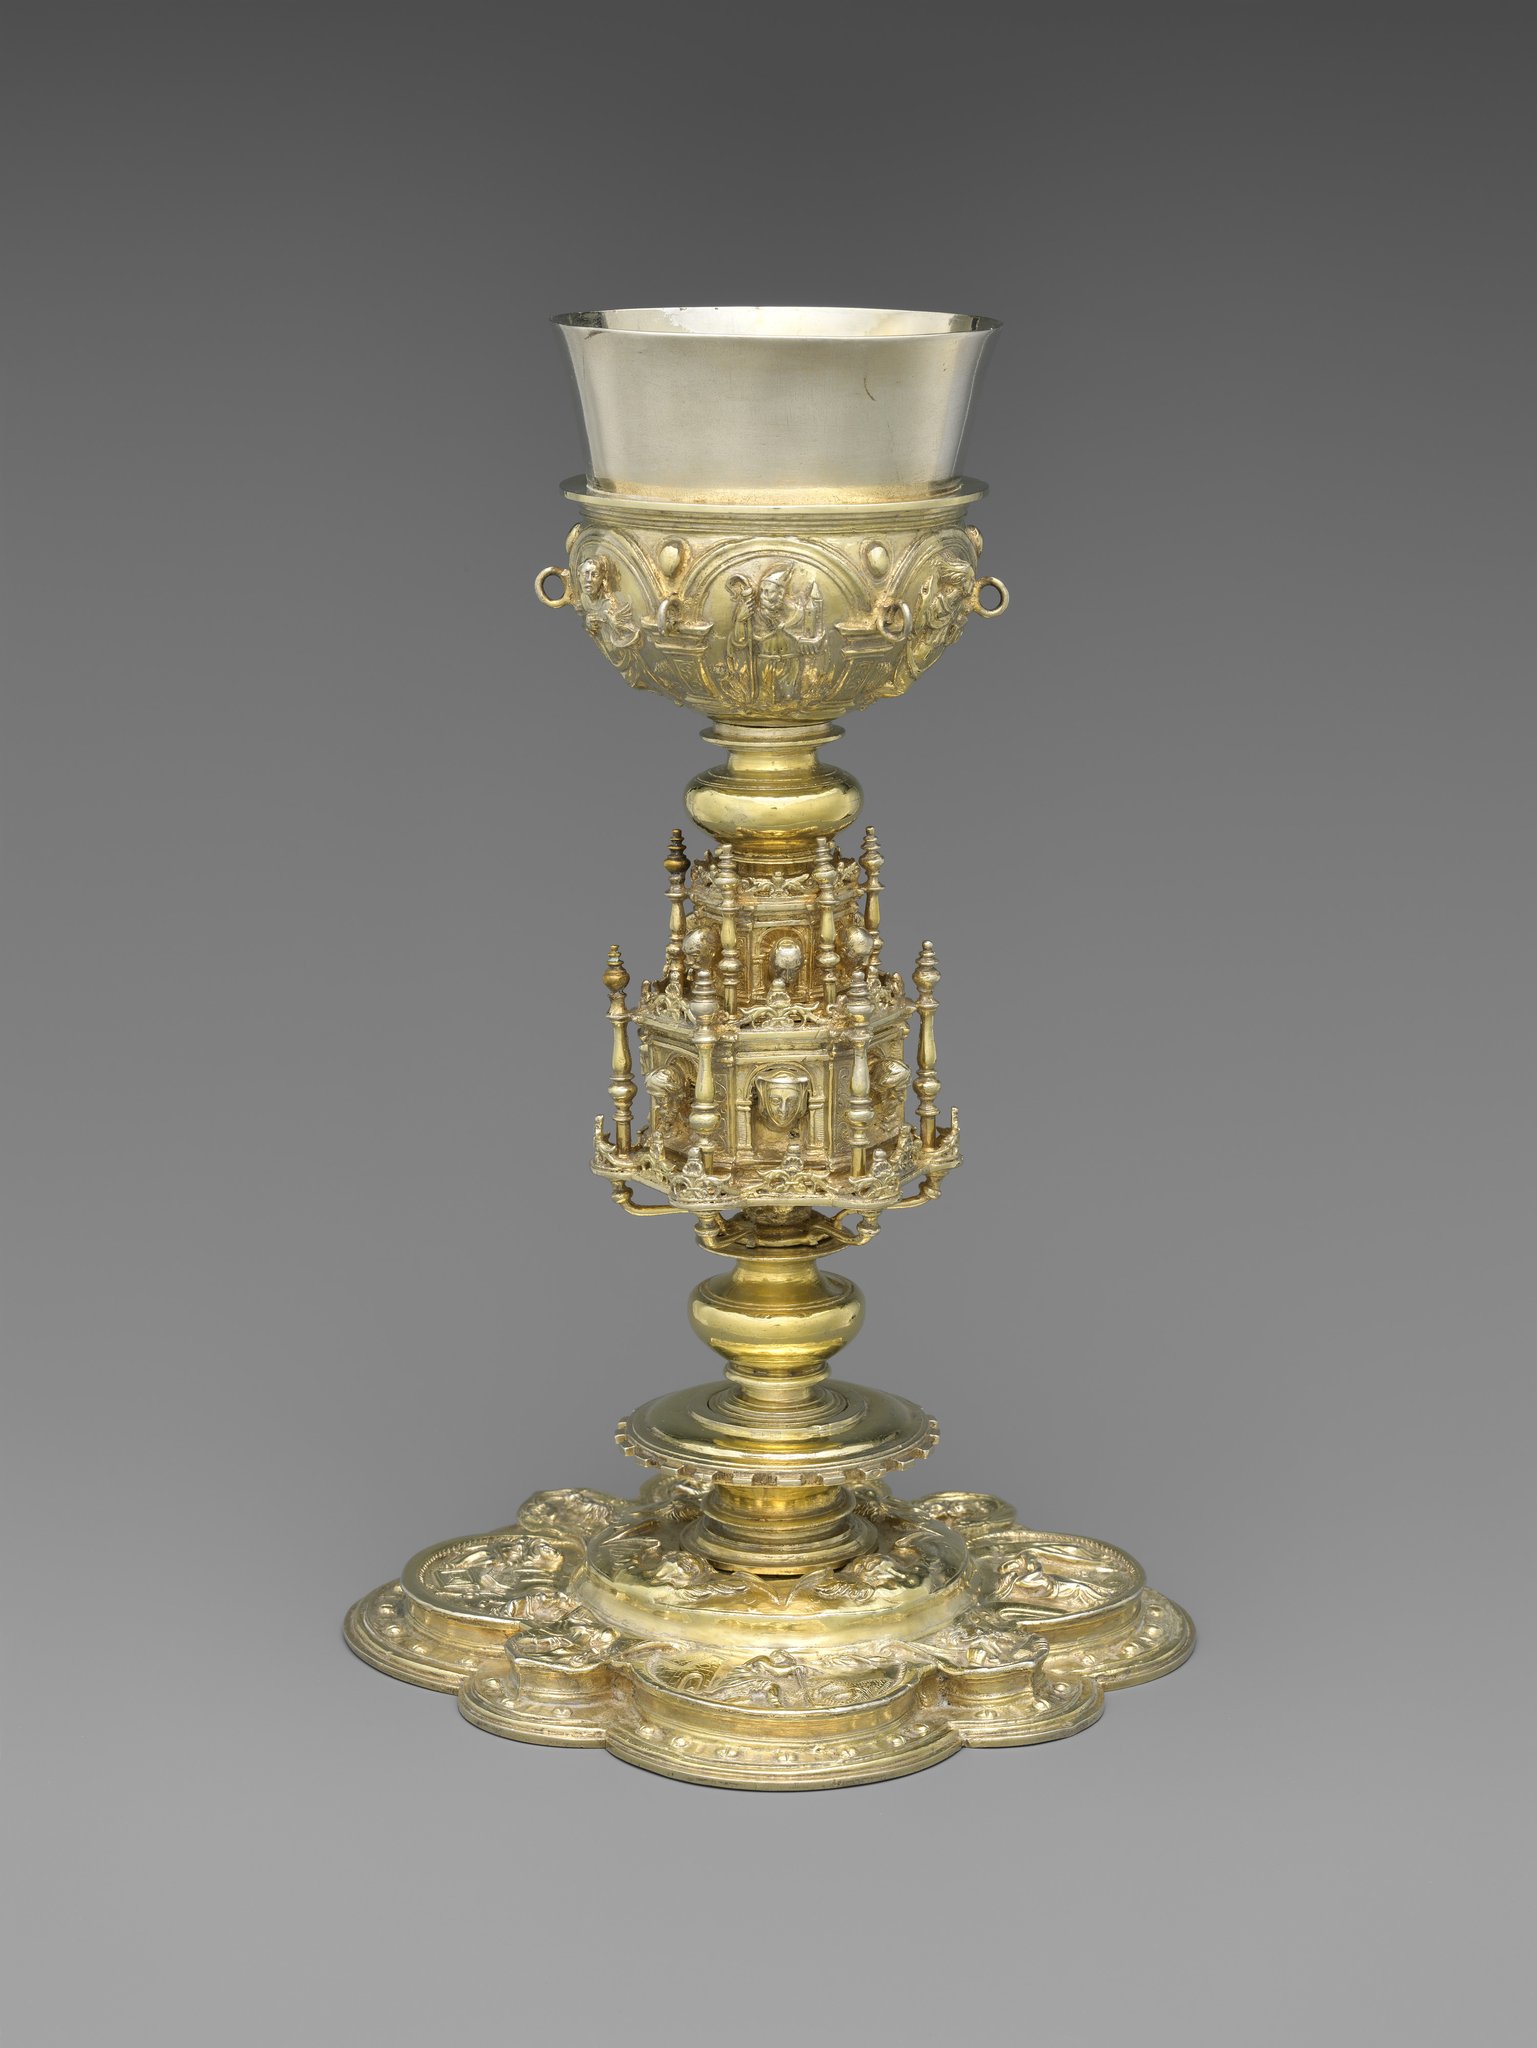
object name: chalice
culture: mexican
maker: antón dantés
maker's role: maker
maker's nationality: mexican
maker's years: 1544-1588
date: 1560-1570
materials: gilt, silver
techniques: burnishing, casting, chasing, repoussé